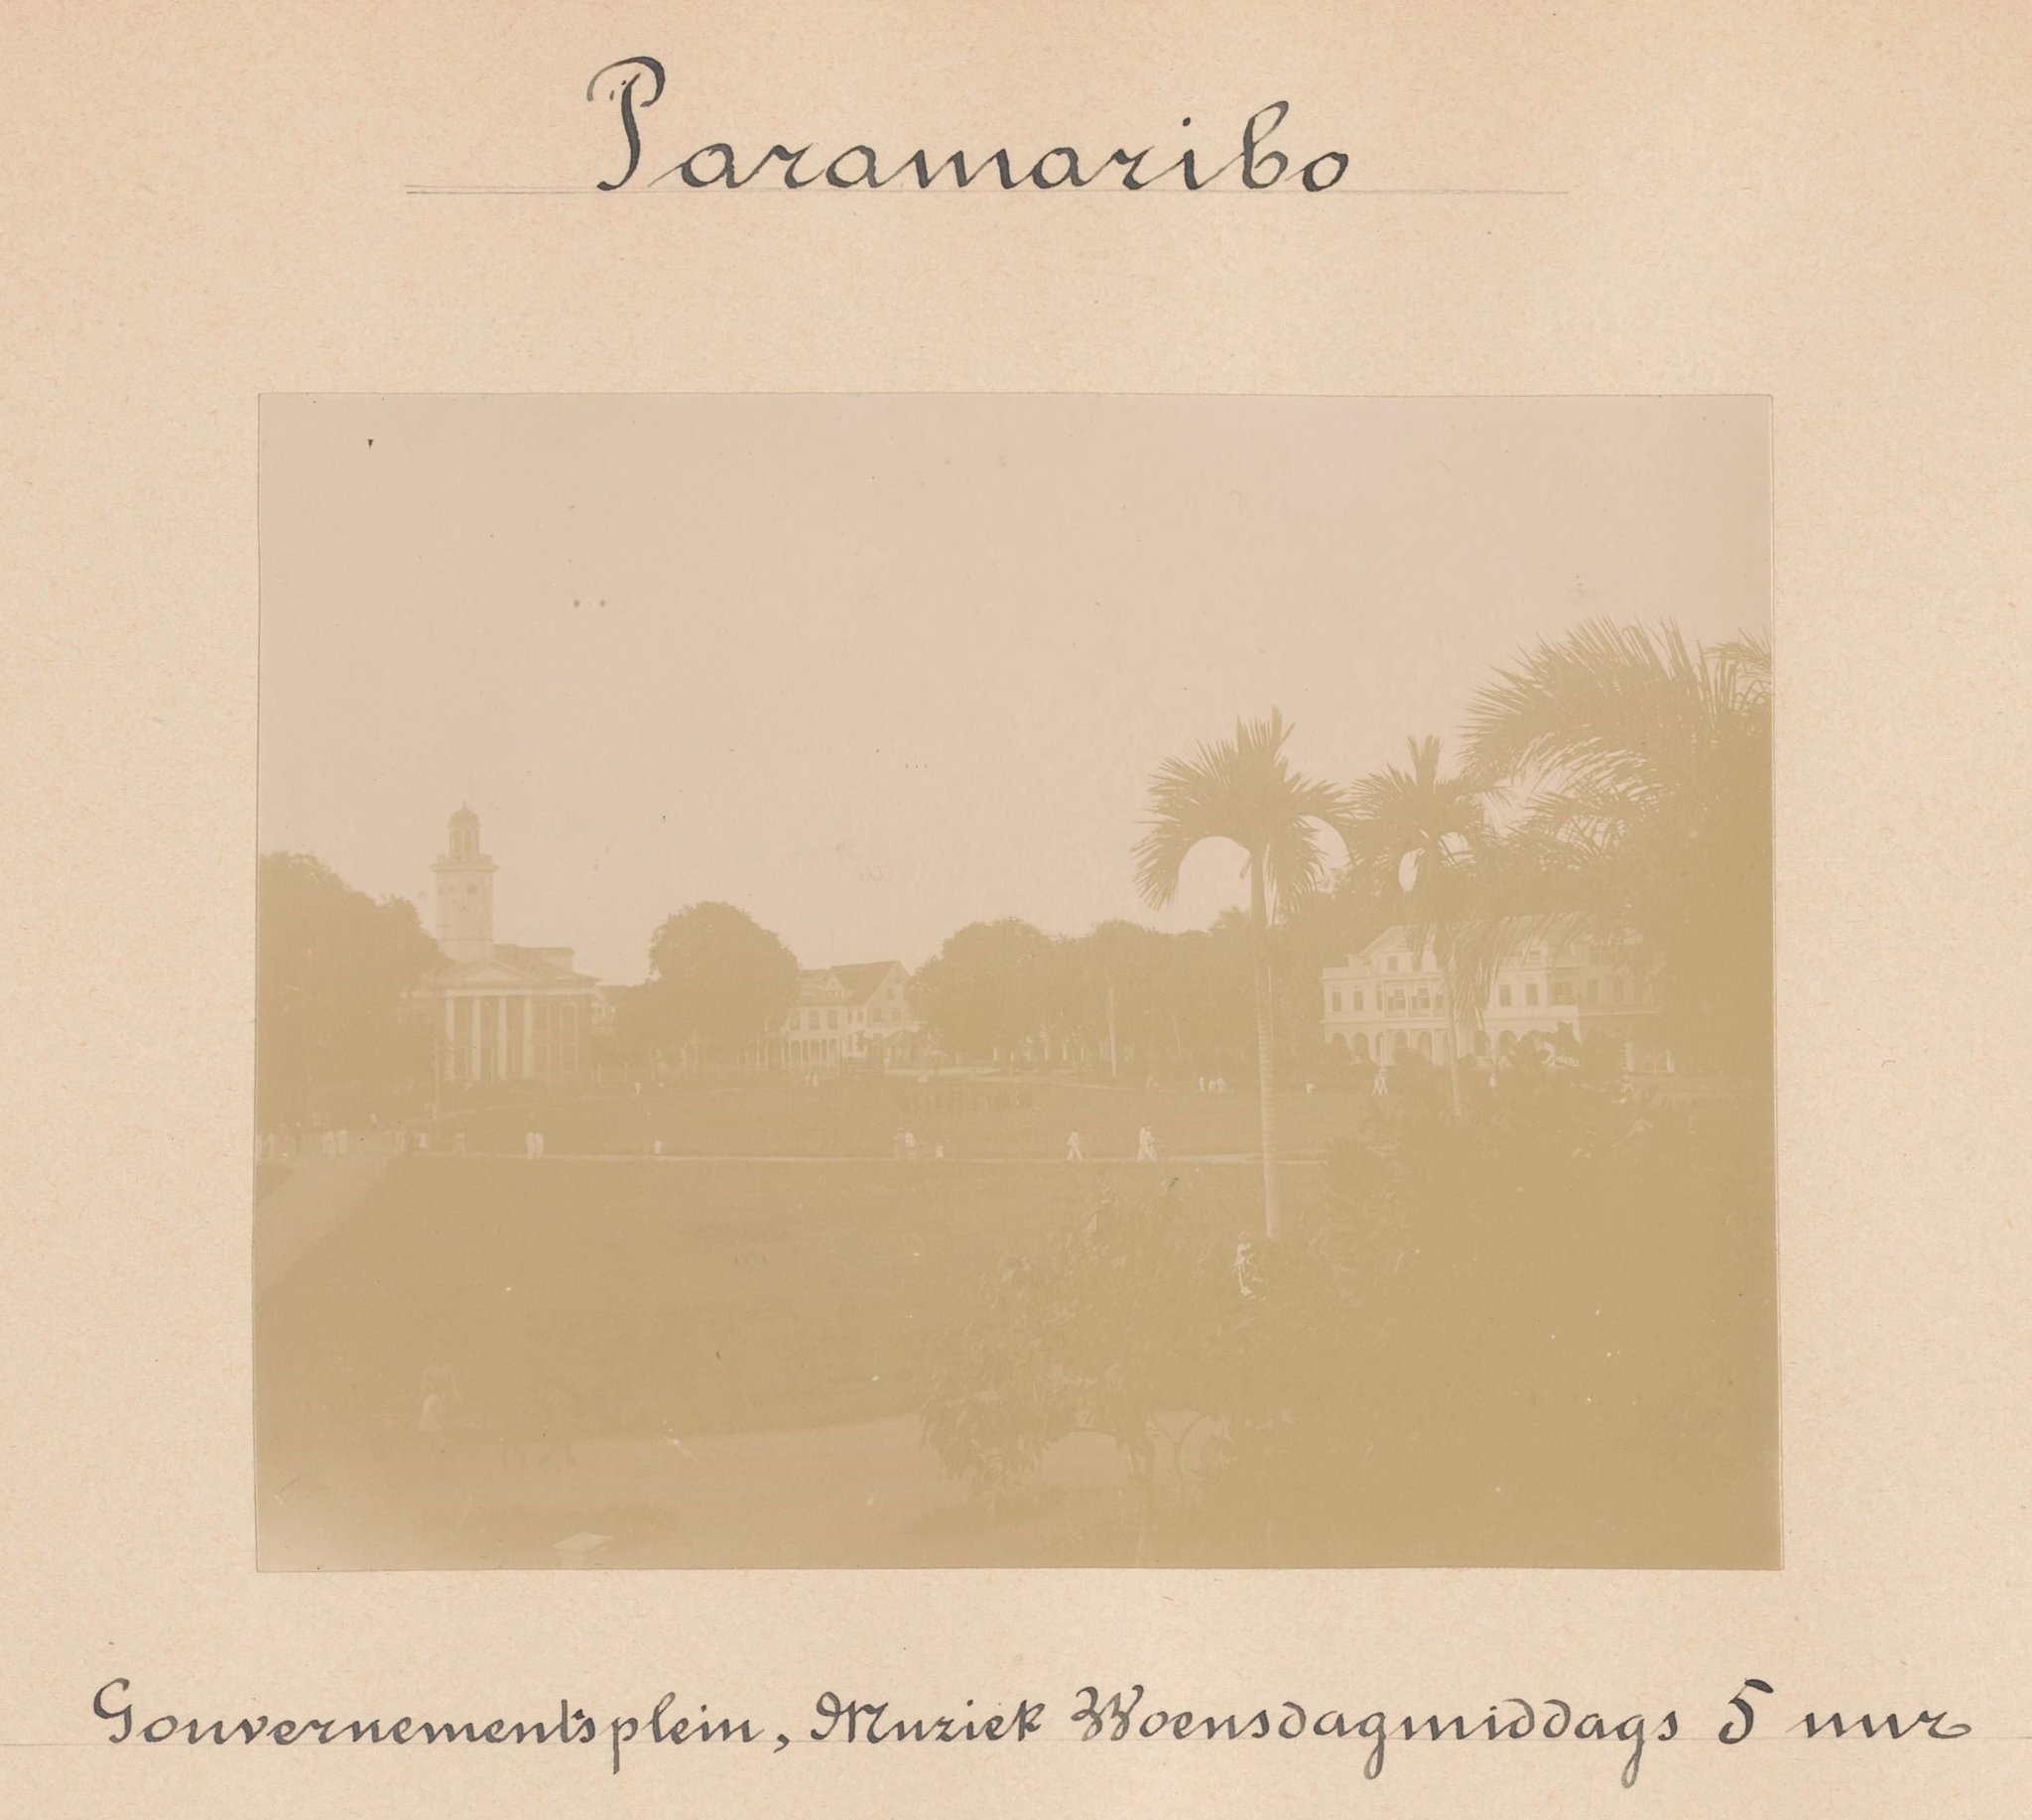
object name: photograph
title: Gouvernementsplein, Muziek Woensdagmiddags 5 uur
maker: eugen klein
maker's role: fotograaf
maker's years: 1869-1927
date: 1900-1905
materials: cardboard, photographic support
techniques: gelatin silver print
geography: paramaribo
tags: gouvernementsplein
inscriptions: inscription: ‘Paramaribo / Gouvernementsplein, Muziek Woensdagmiddags 5 uur’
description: Gezicht op het Gouvernementsplein te Paramaribo. Onderdeel van een groep van 44 foto's van Paramaribo, Suriname en Curaçao, ca. 1900-1905, opgeplakt op kartons en voorzien van opschriften.